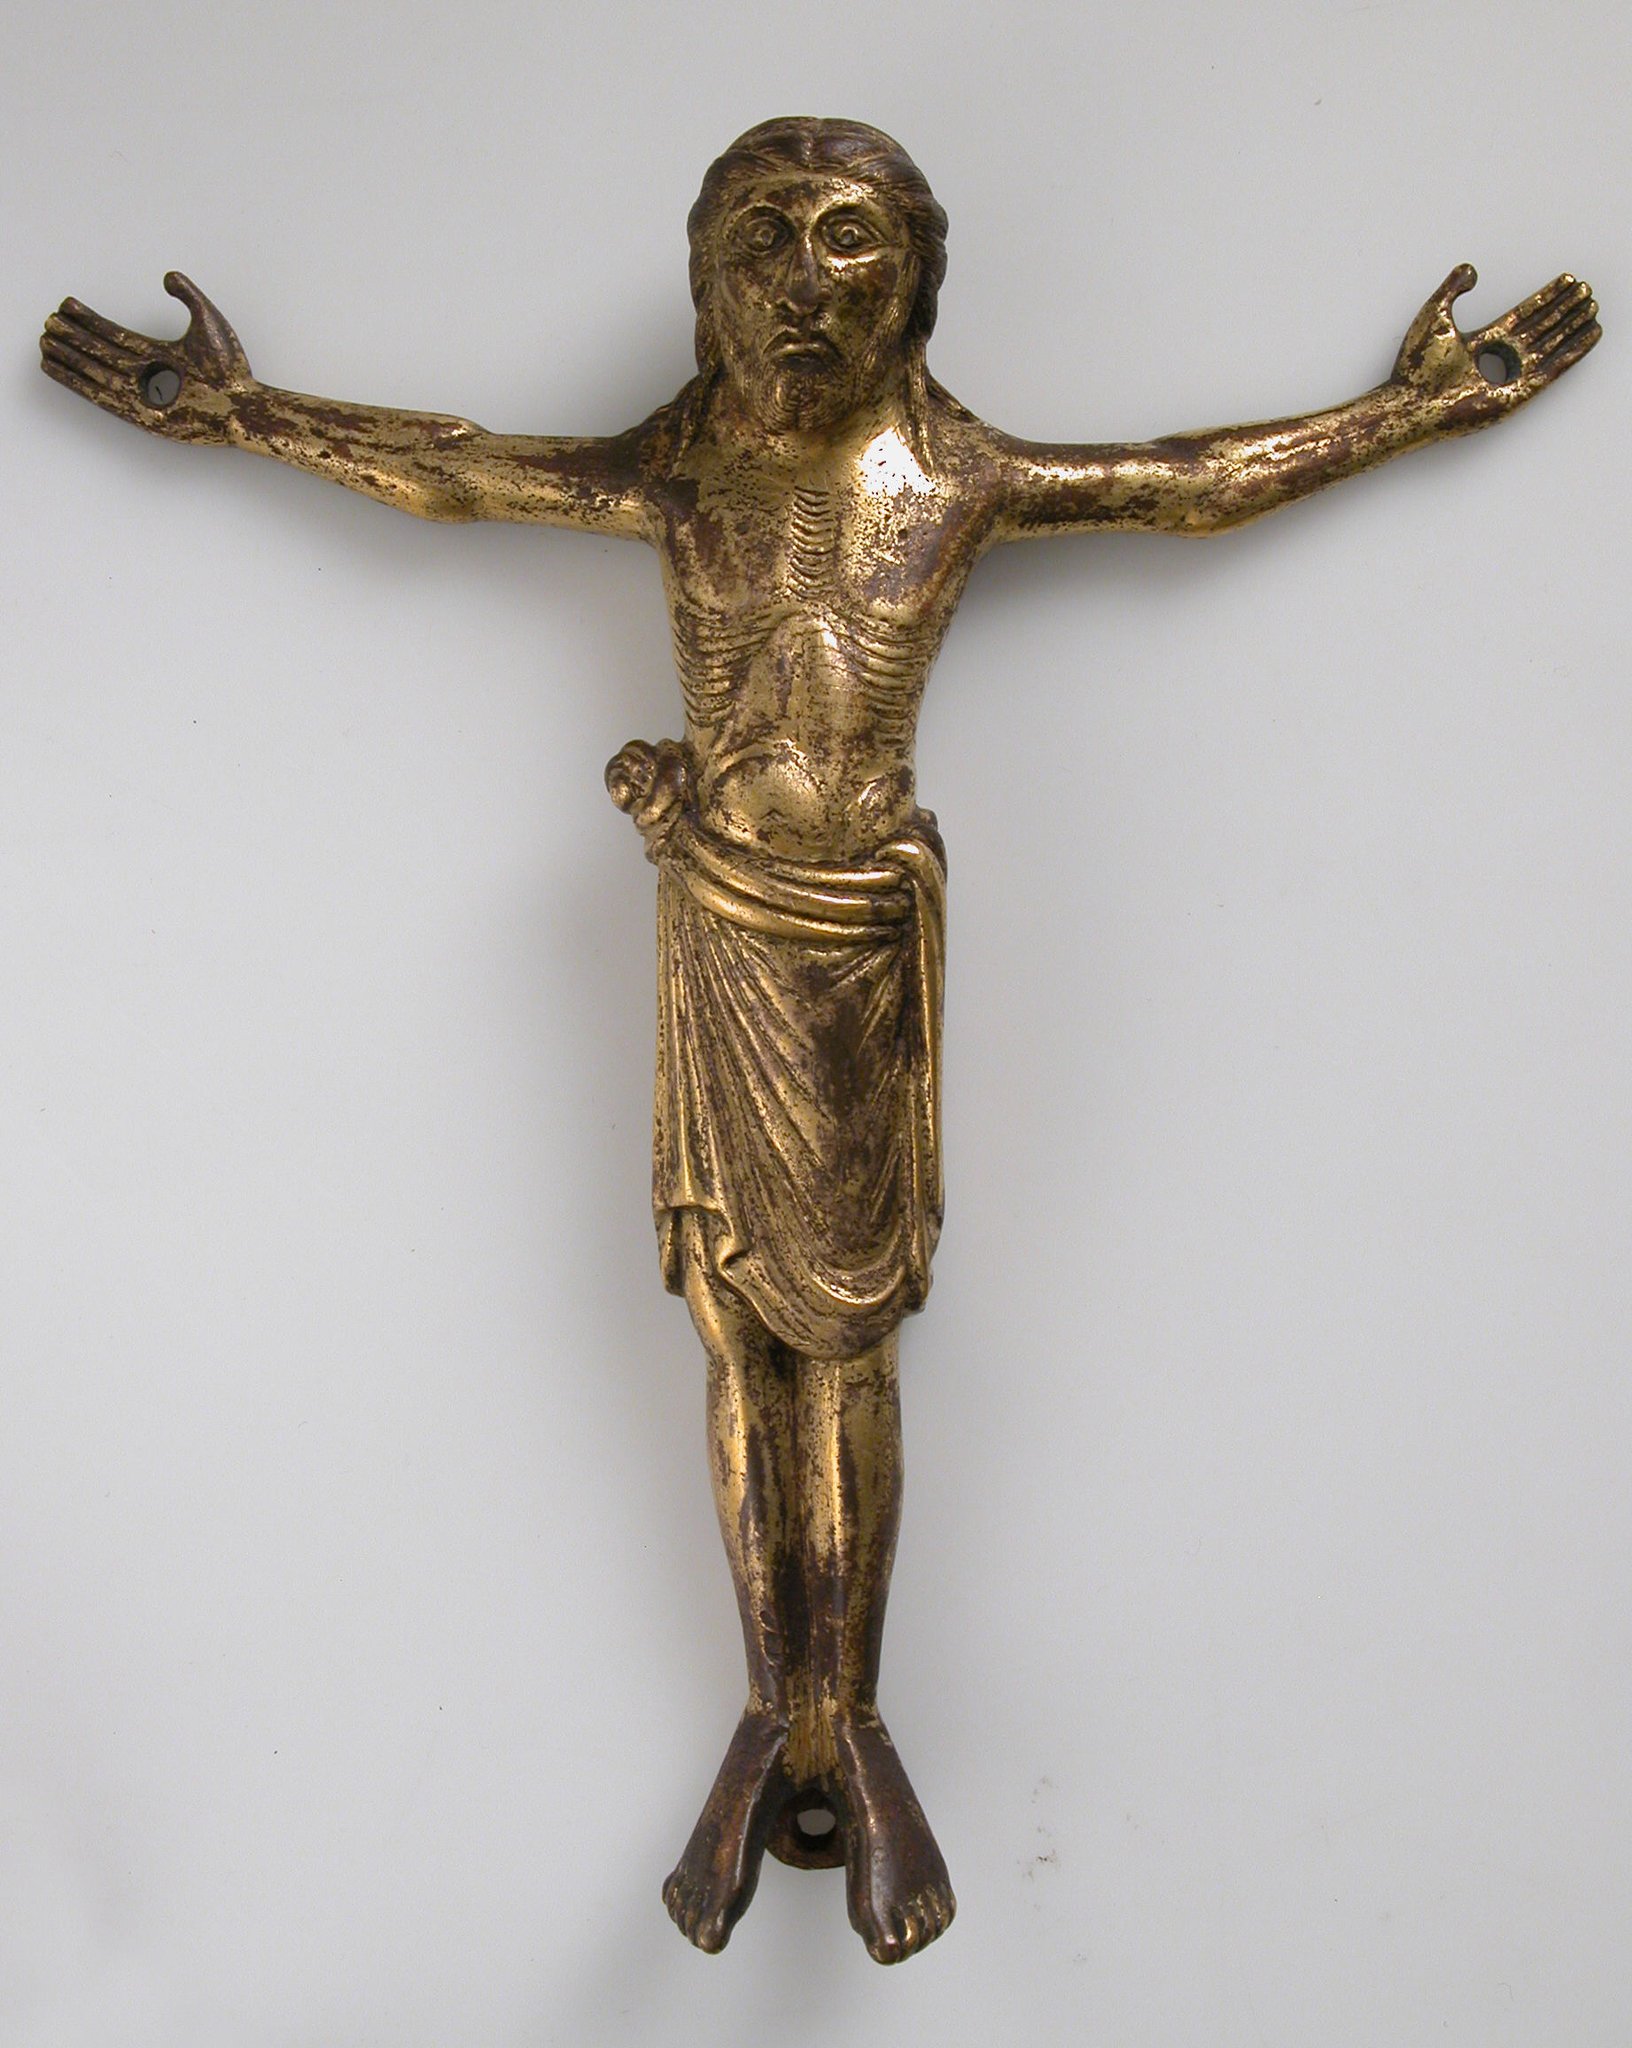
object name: corpus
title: Crucified Christ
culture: german or south netherlandish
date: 1140-1160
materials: copper alloy, gilt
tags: christ,crucifixion